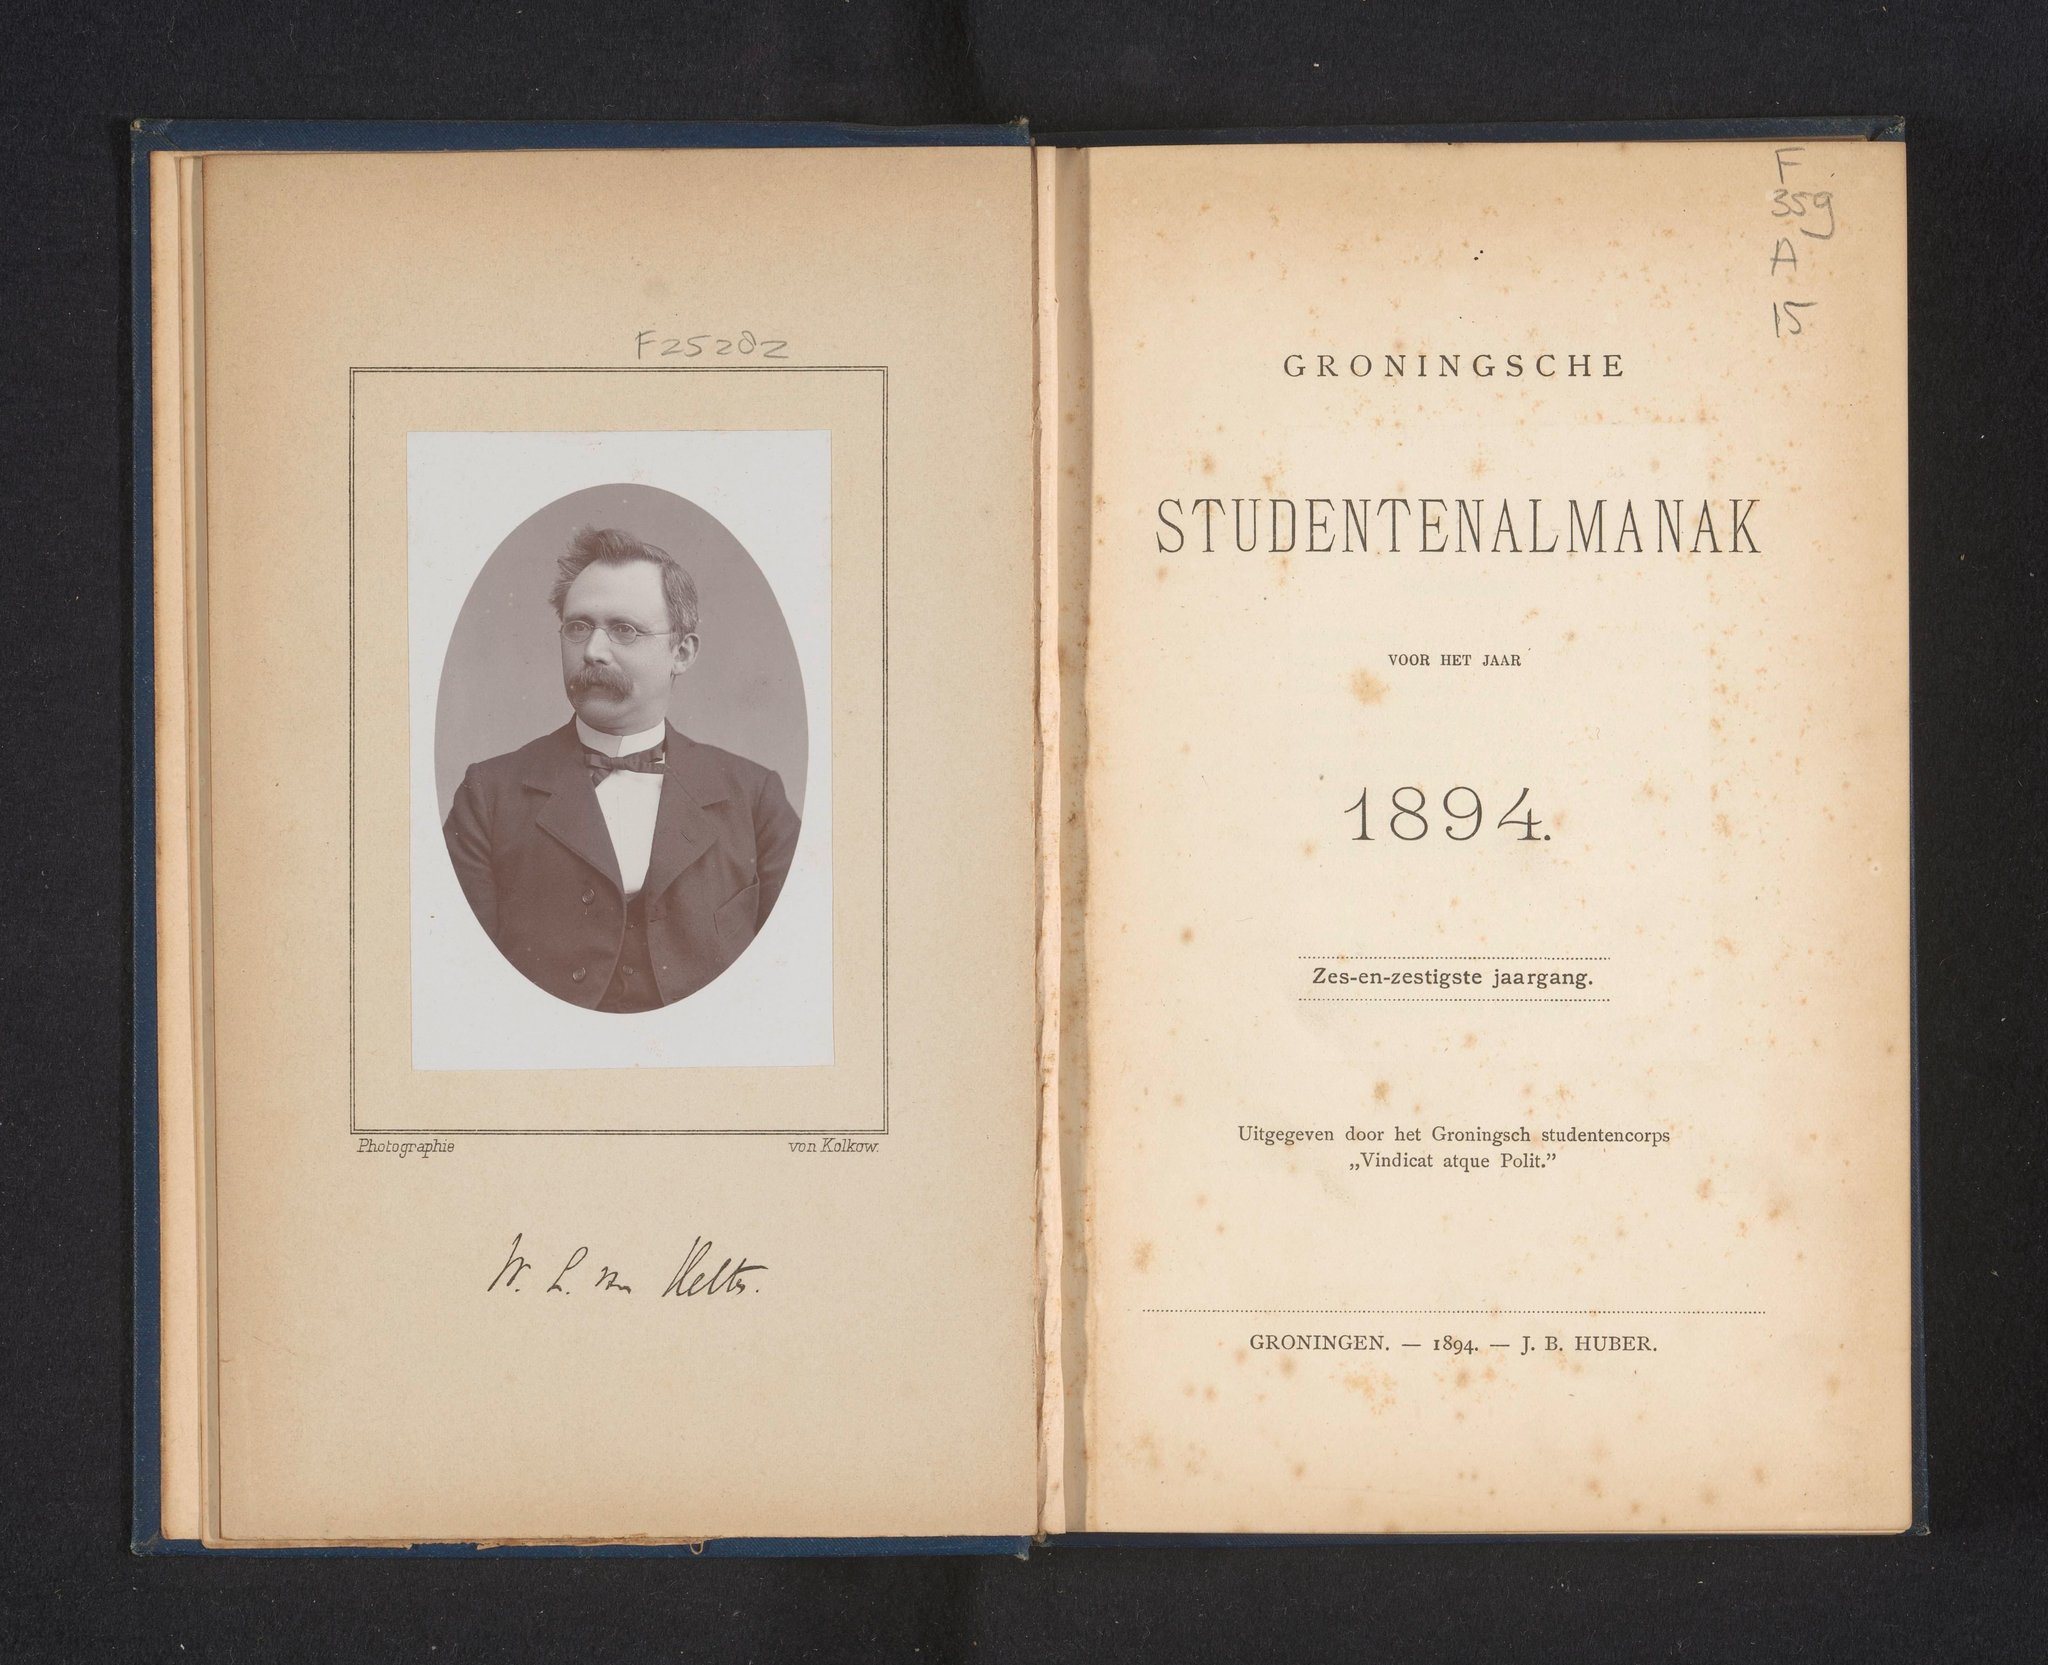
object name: photograph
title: Portret van Willem Lodewijk van Helten, hoogleraar letteren en wijsbegeerte in Groningen en rector magnificus van 1893 tot 1894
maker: friedrich julius von kolkow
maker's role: fotograaf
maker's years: 1839-1914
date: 1889-1894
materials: photographic support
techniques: collodion silver print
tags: the hague, historical persons, professor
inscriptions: name: ‘W. L. van Helten.’